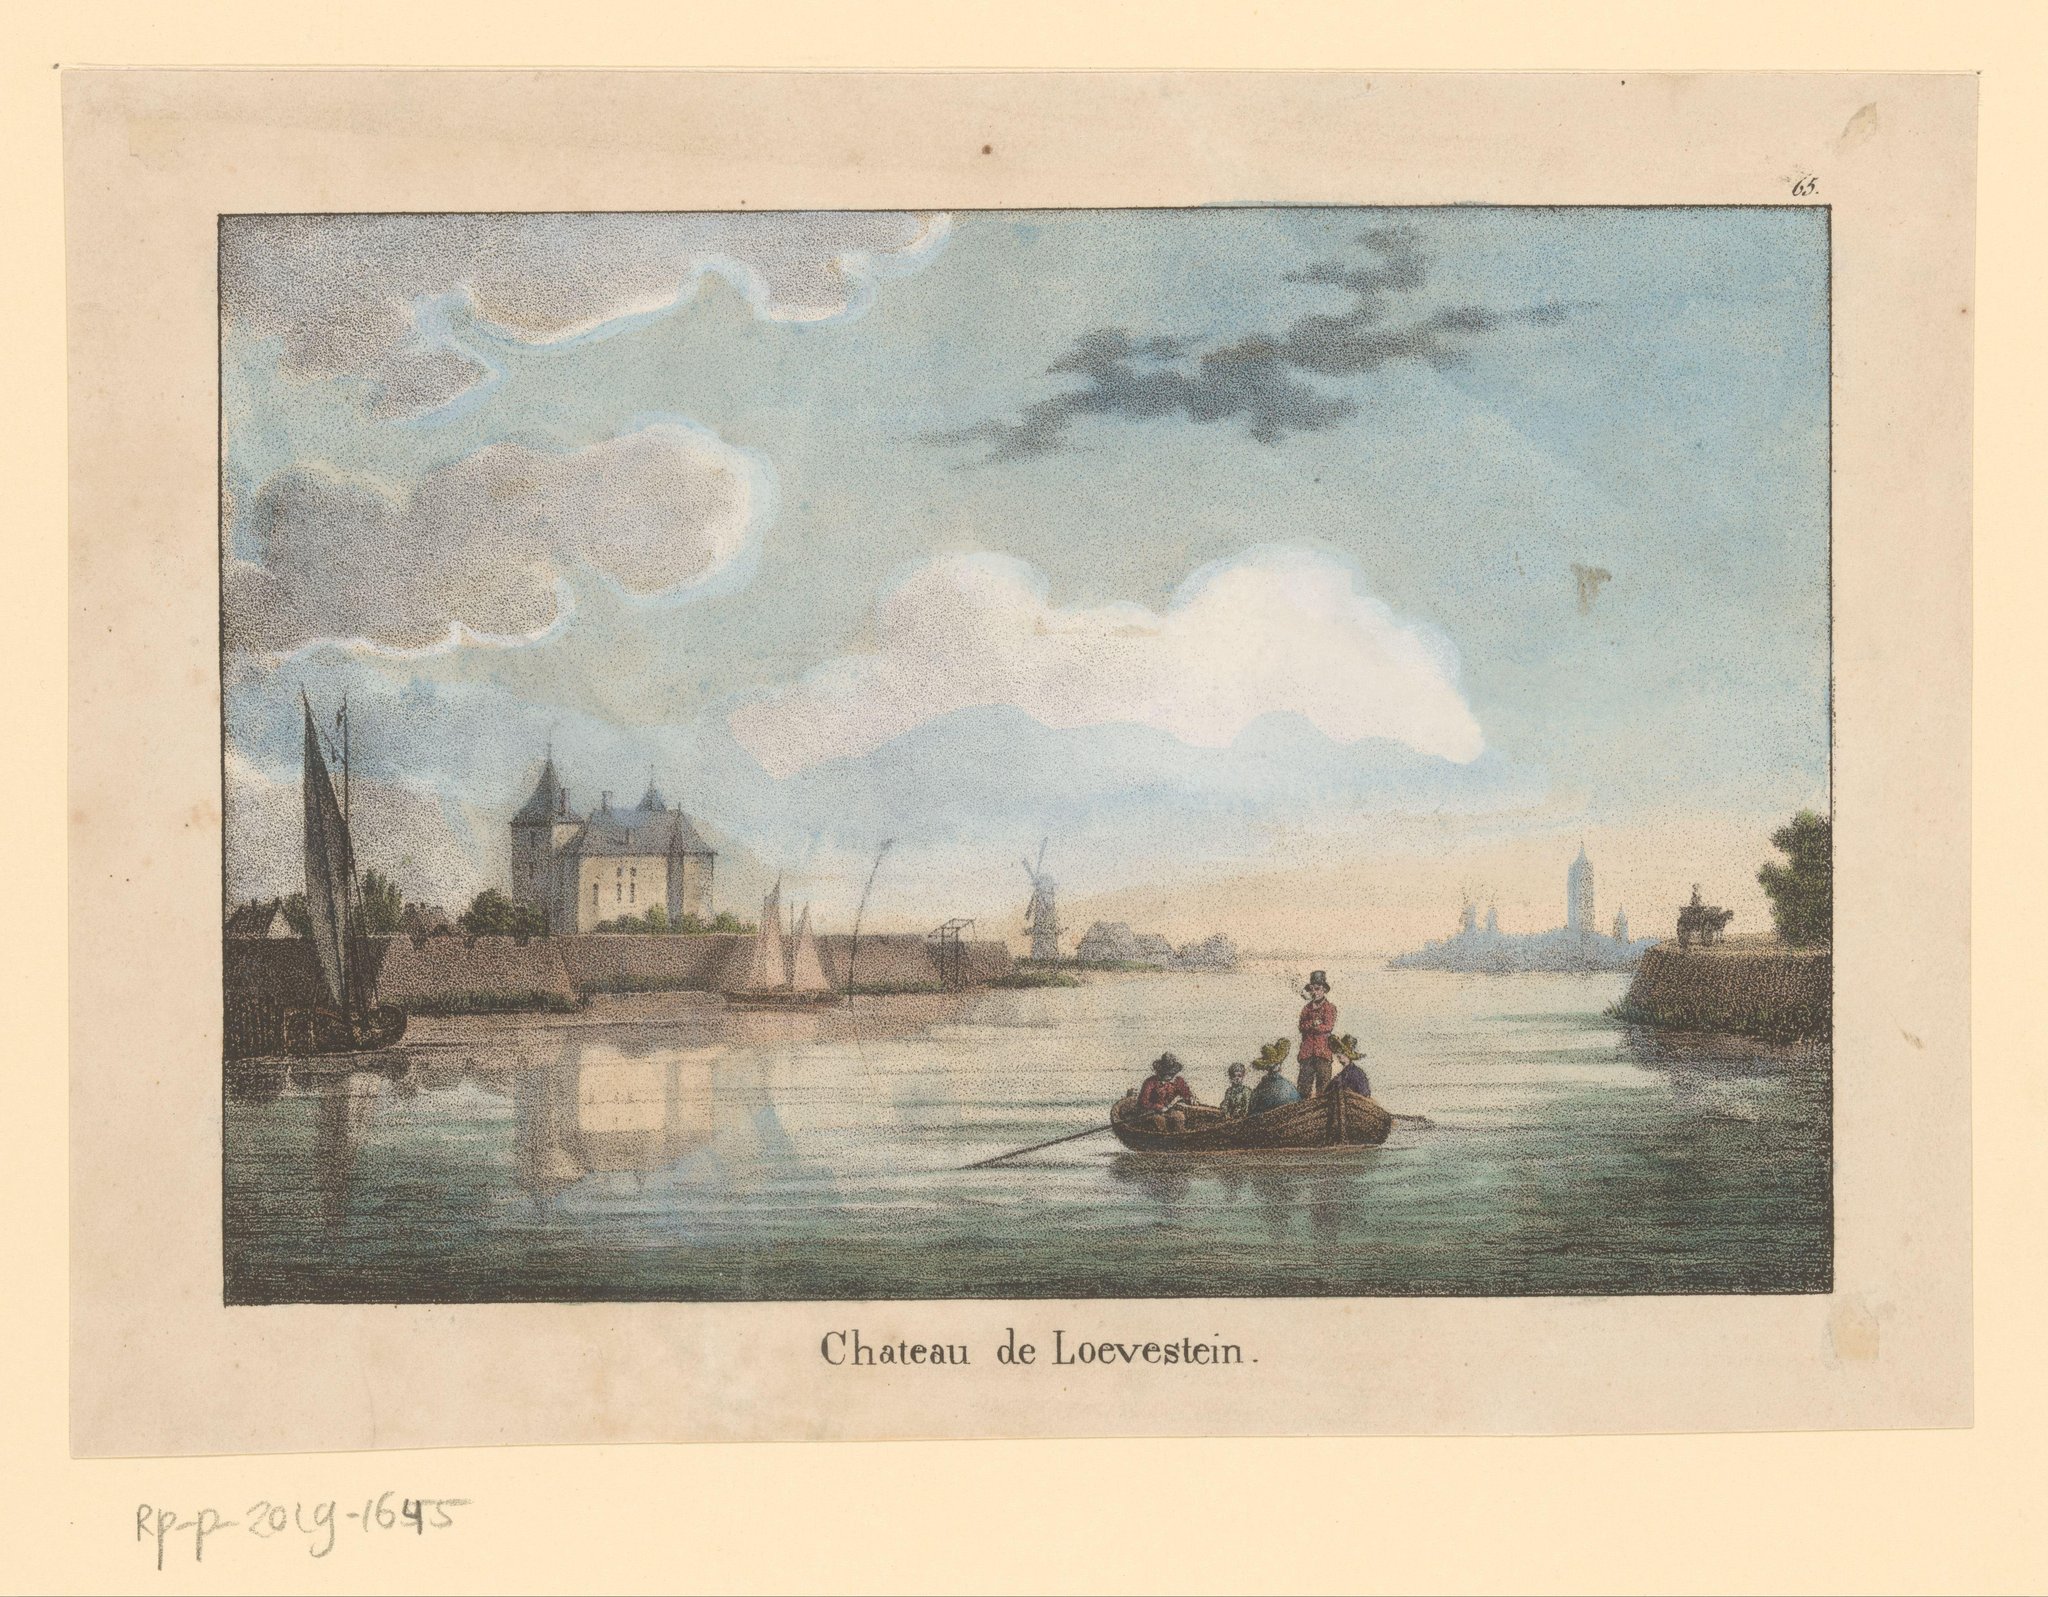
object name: print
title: Gezicht op Slot Loevestein vanaf de Waal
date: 1825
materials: paper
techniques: lithograph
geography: brussels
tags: castle, landscape with tower or castle, river (+ landscape with figures, staffage), loevestein castle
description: Prent uit: Cloet, J.J. de. Voyage pittoresque dans le royaume des Pays Bas (...). Brussel: J.B.A.M. Jobard, 1825.